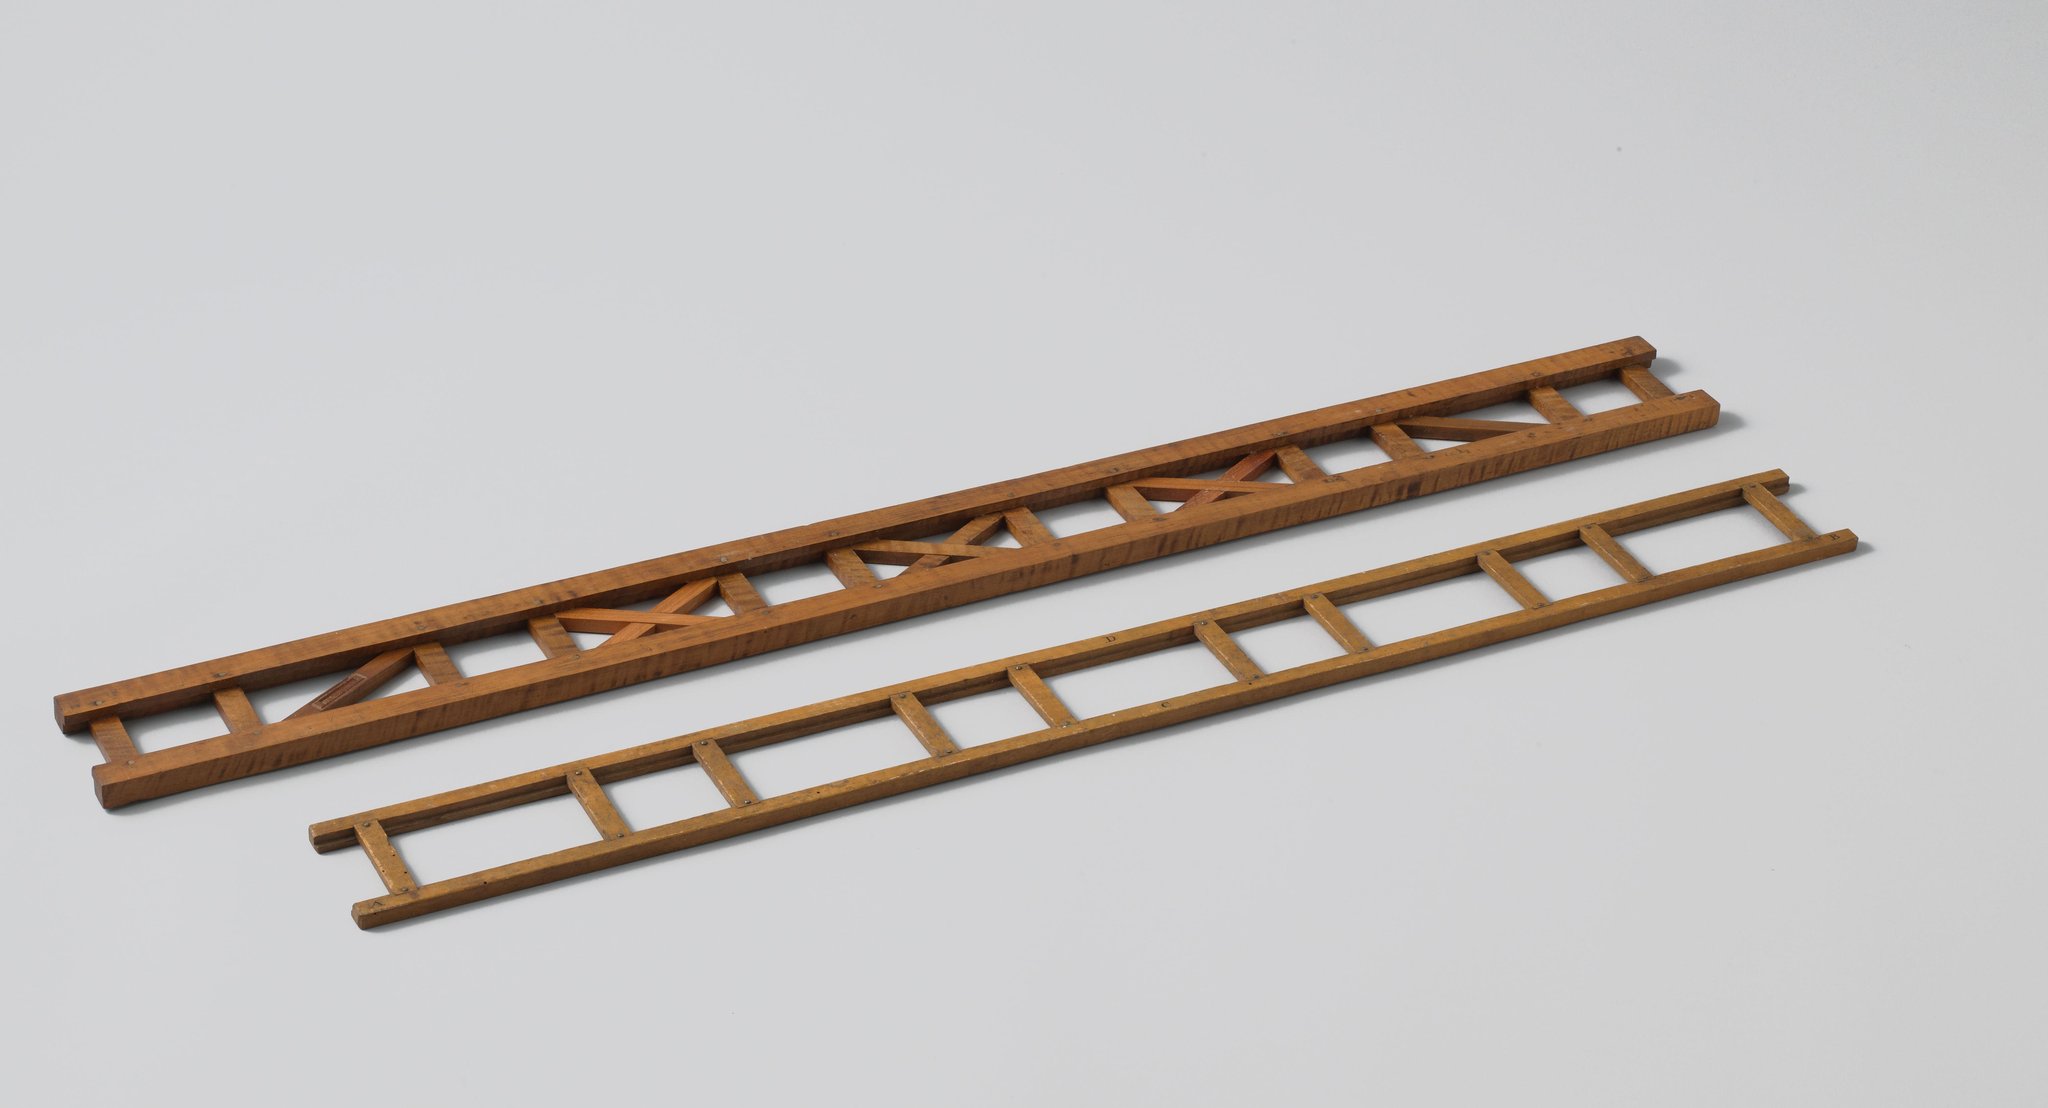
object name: instruction model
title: Model of Diagonal Framing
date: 1822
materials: brass, wood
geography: united kingdom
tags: england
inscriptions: label: parts labelled A to D and numbered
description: Model dat het kruisverband tussen de geschutpoorten volgens Seppings demonstreert. Het bestaat uit twee wegeringbalken, waartussen poorten en diagonale schoren, steunders en sleutels zijn aangebracht.